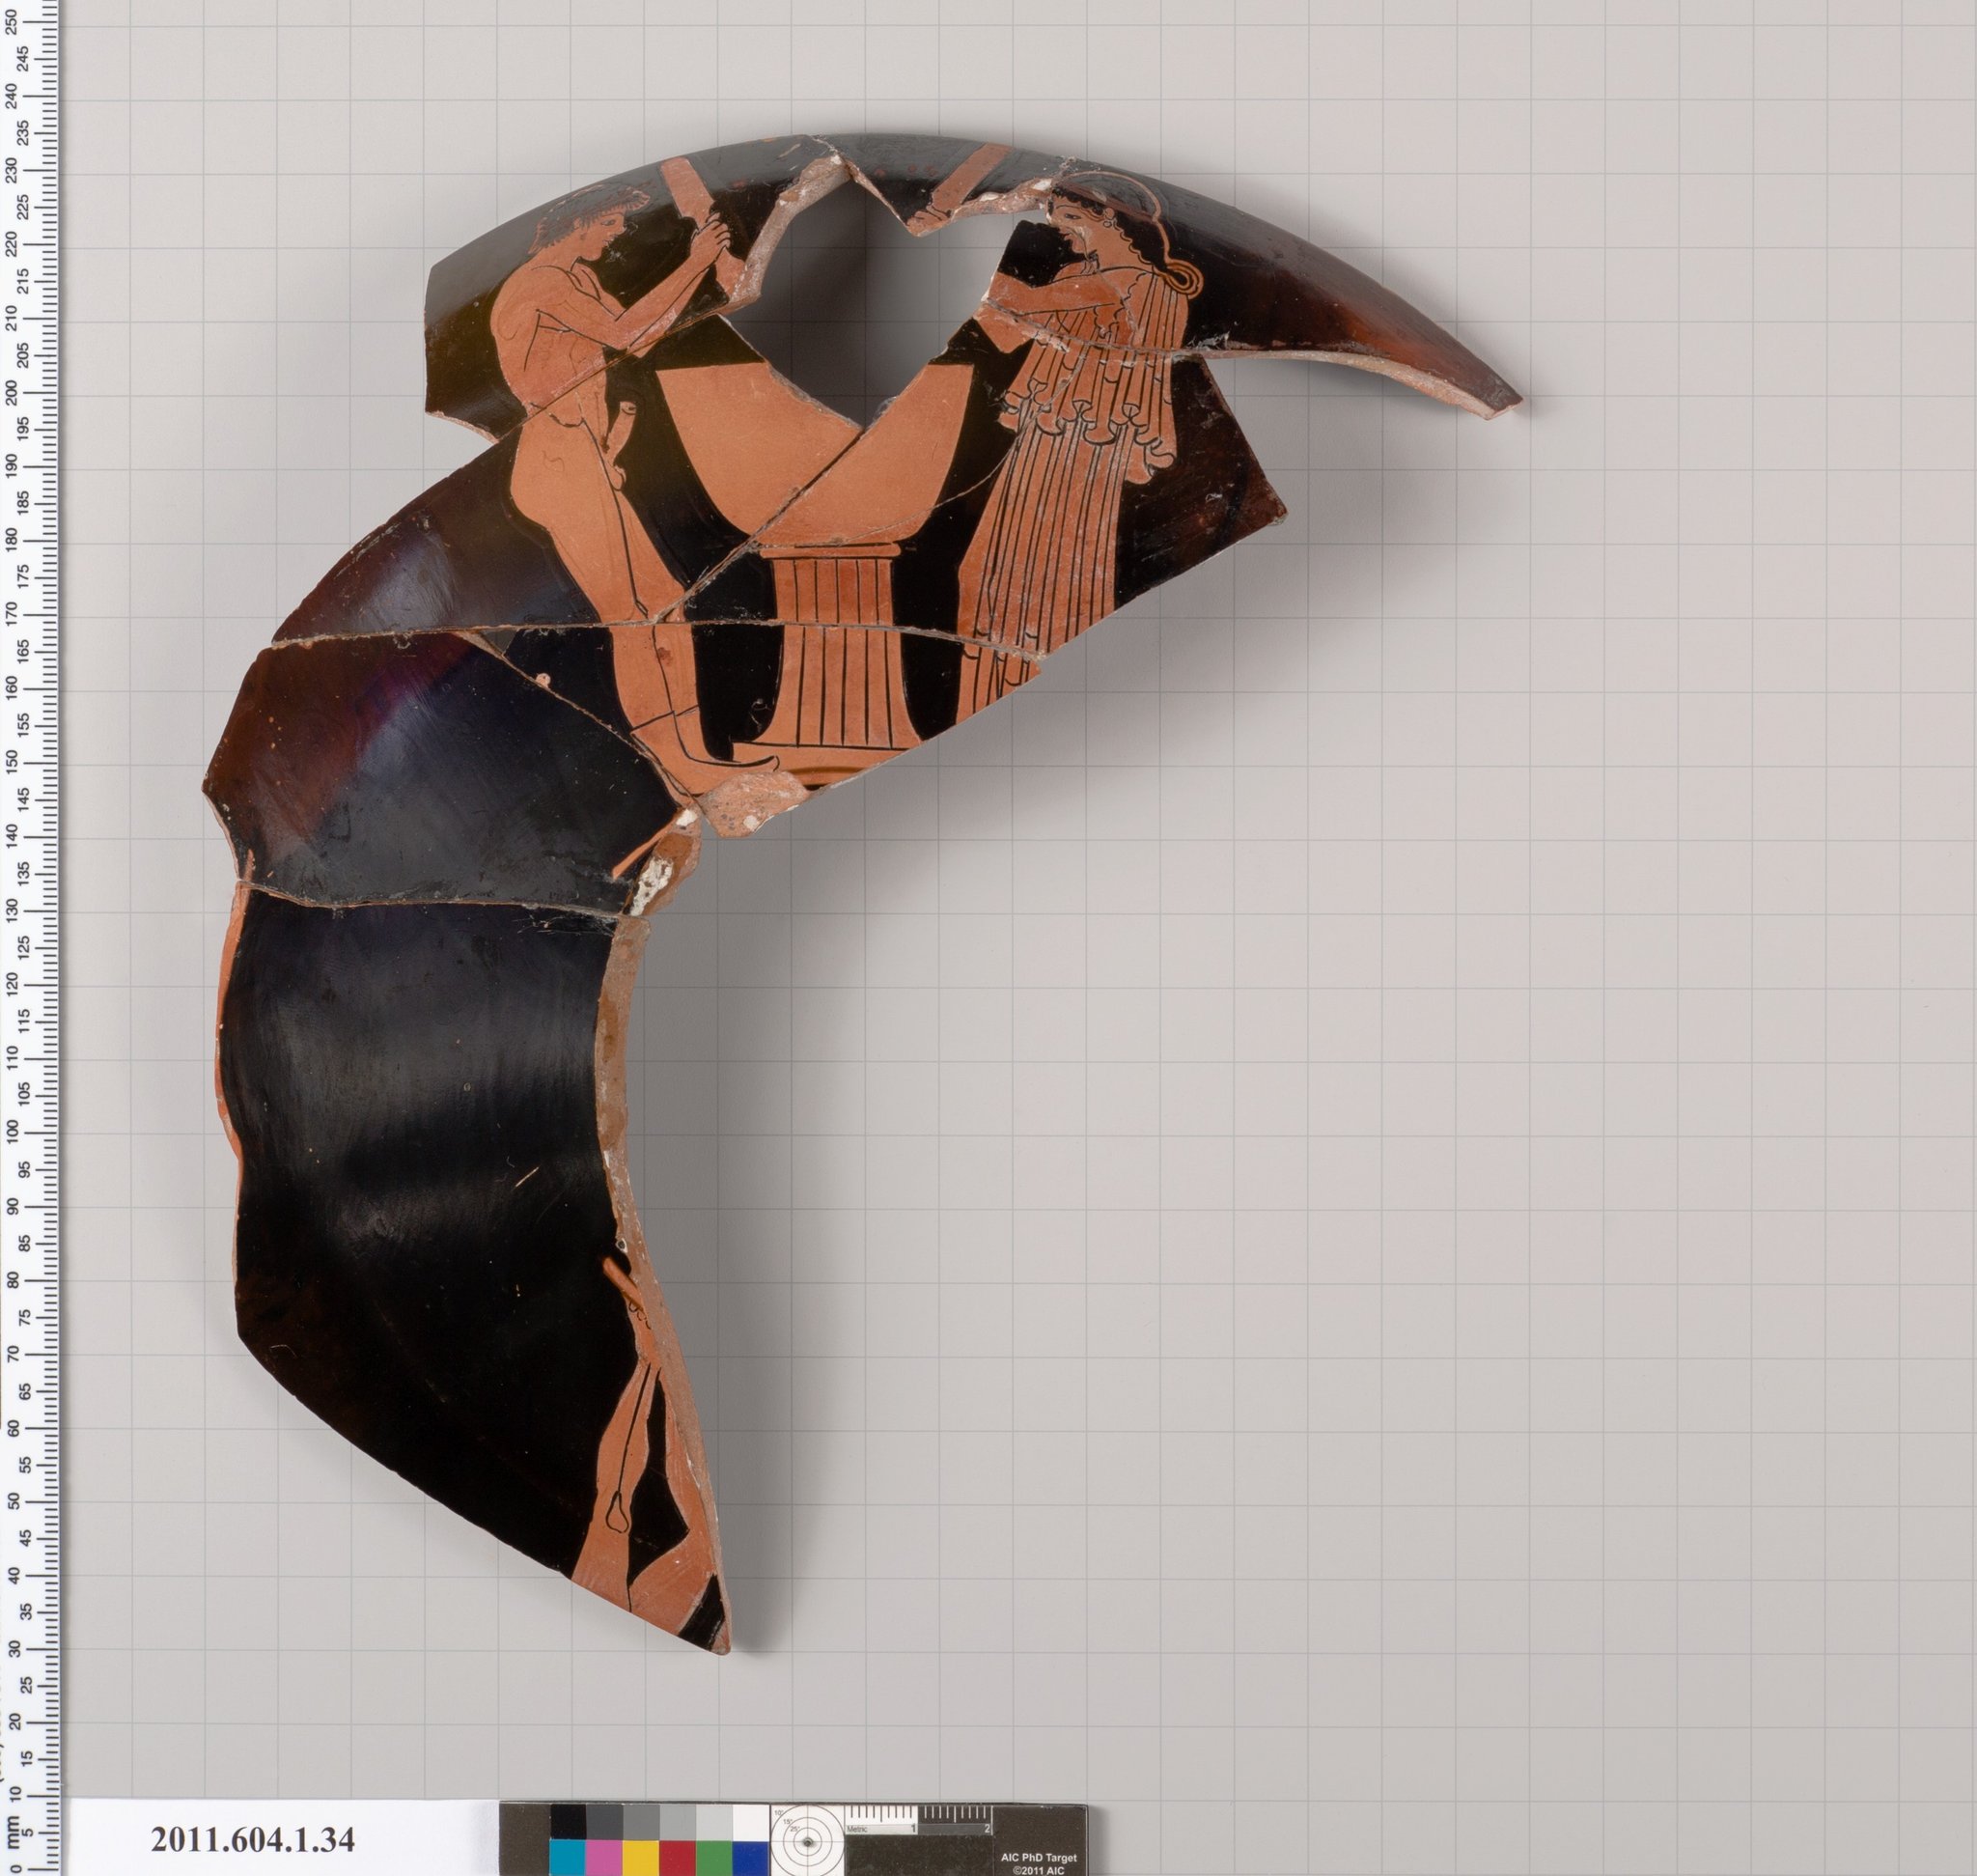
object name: kylix fragment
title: Terracotta fragments of a kylix (drinking cup)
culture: greek, attic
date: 490-480 BCE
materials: terracotta